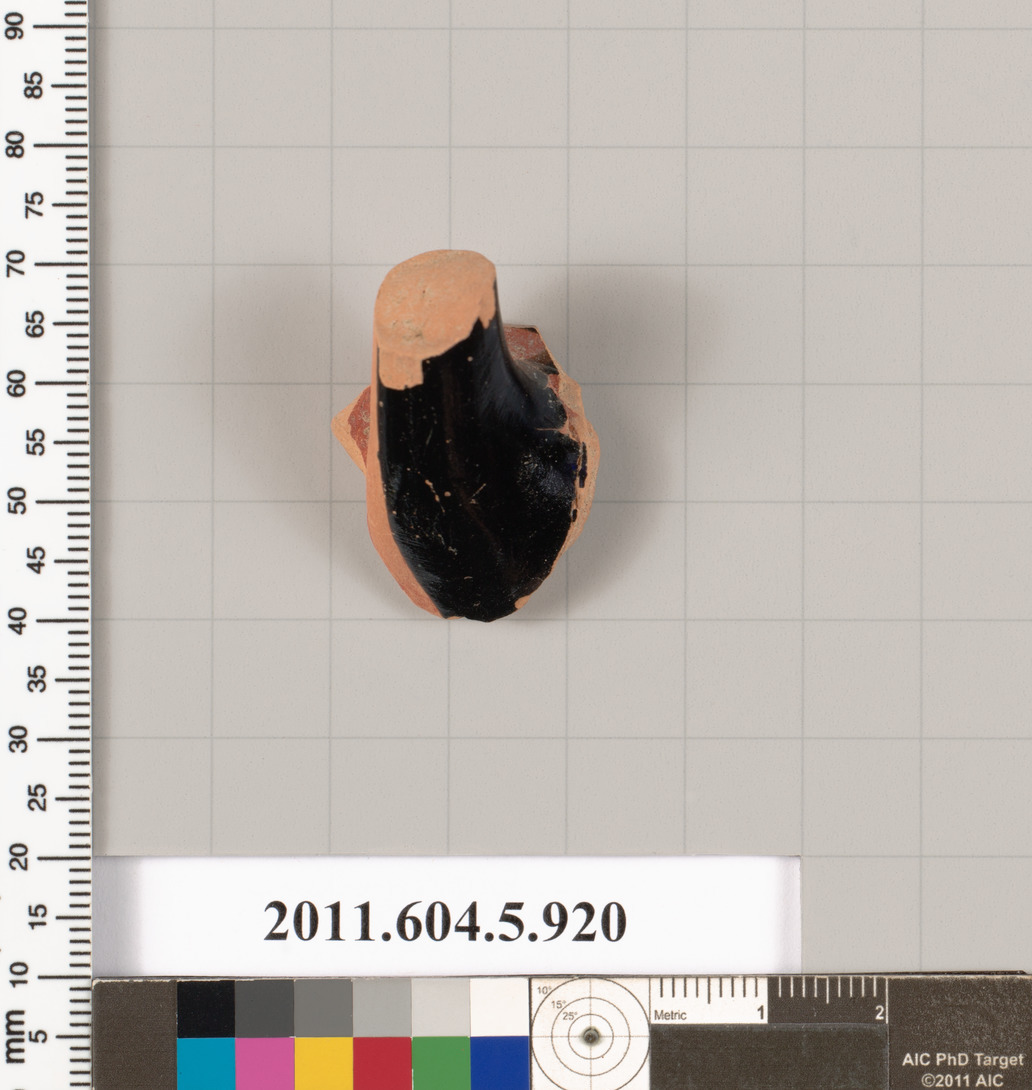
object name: kylix fragment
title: Terracotta fragment of a kylix (drinking cup)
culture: greek, attic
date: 600-401 BCE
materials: terracotta